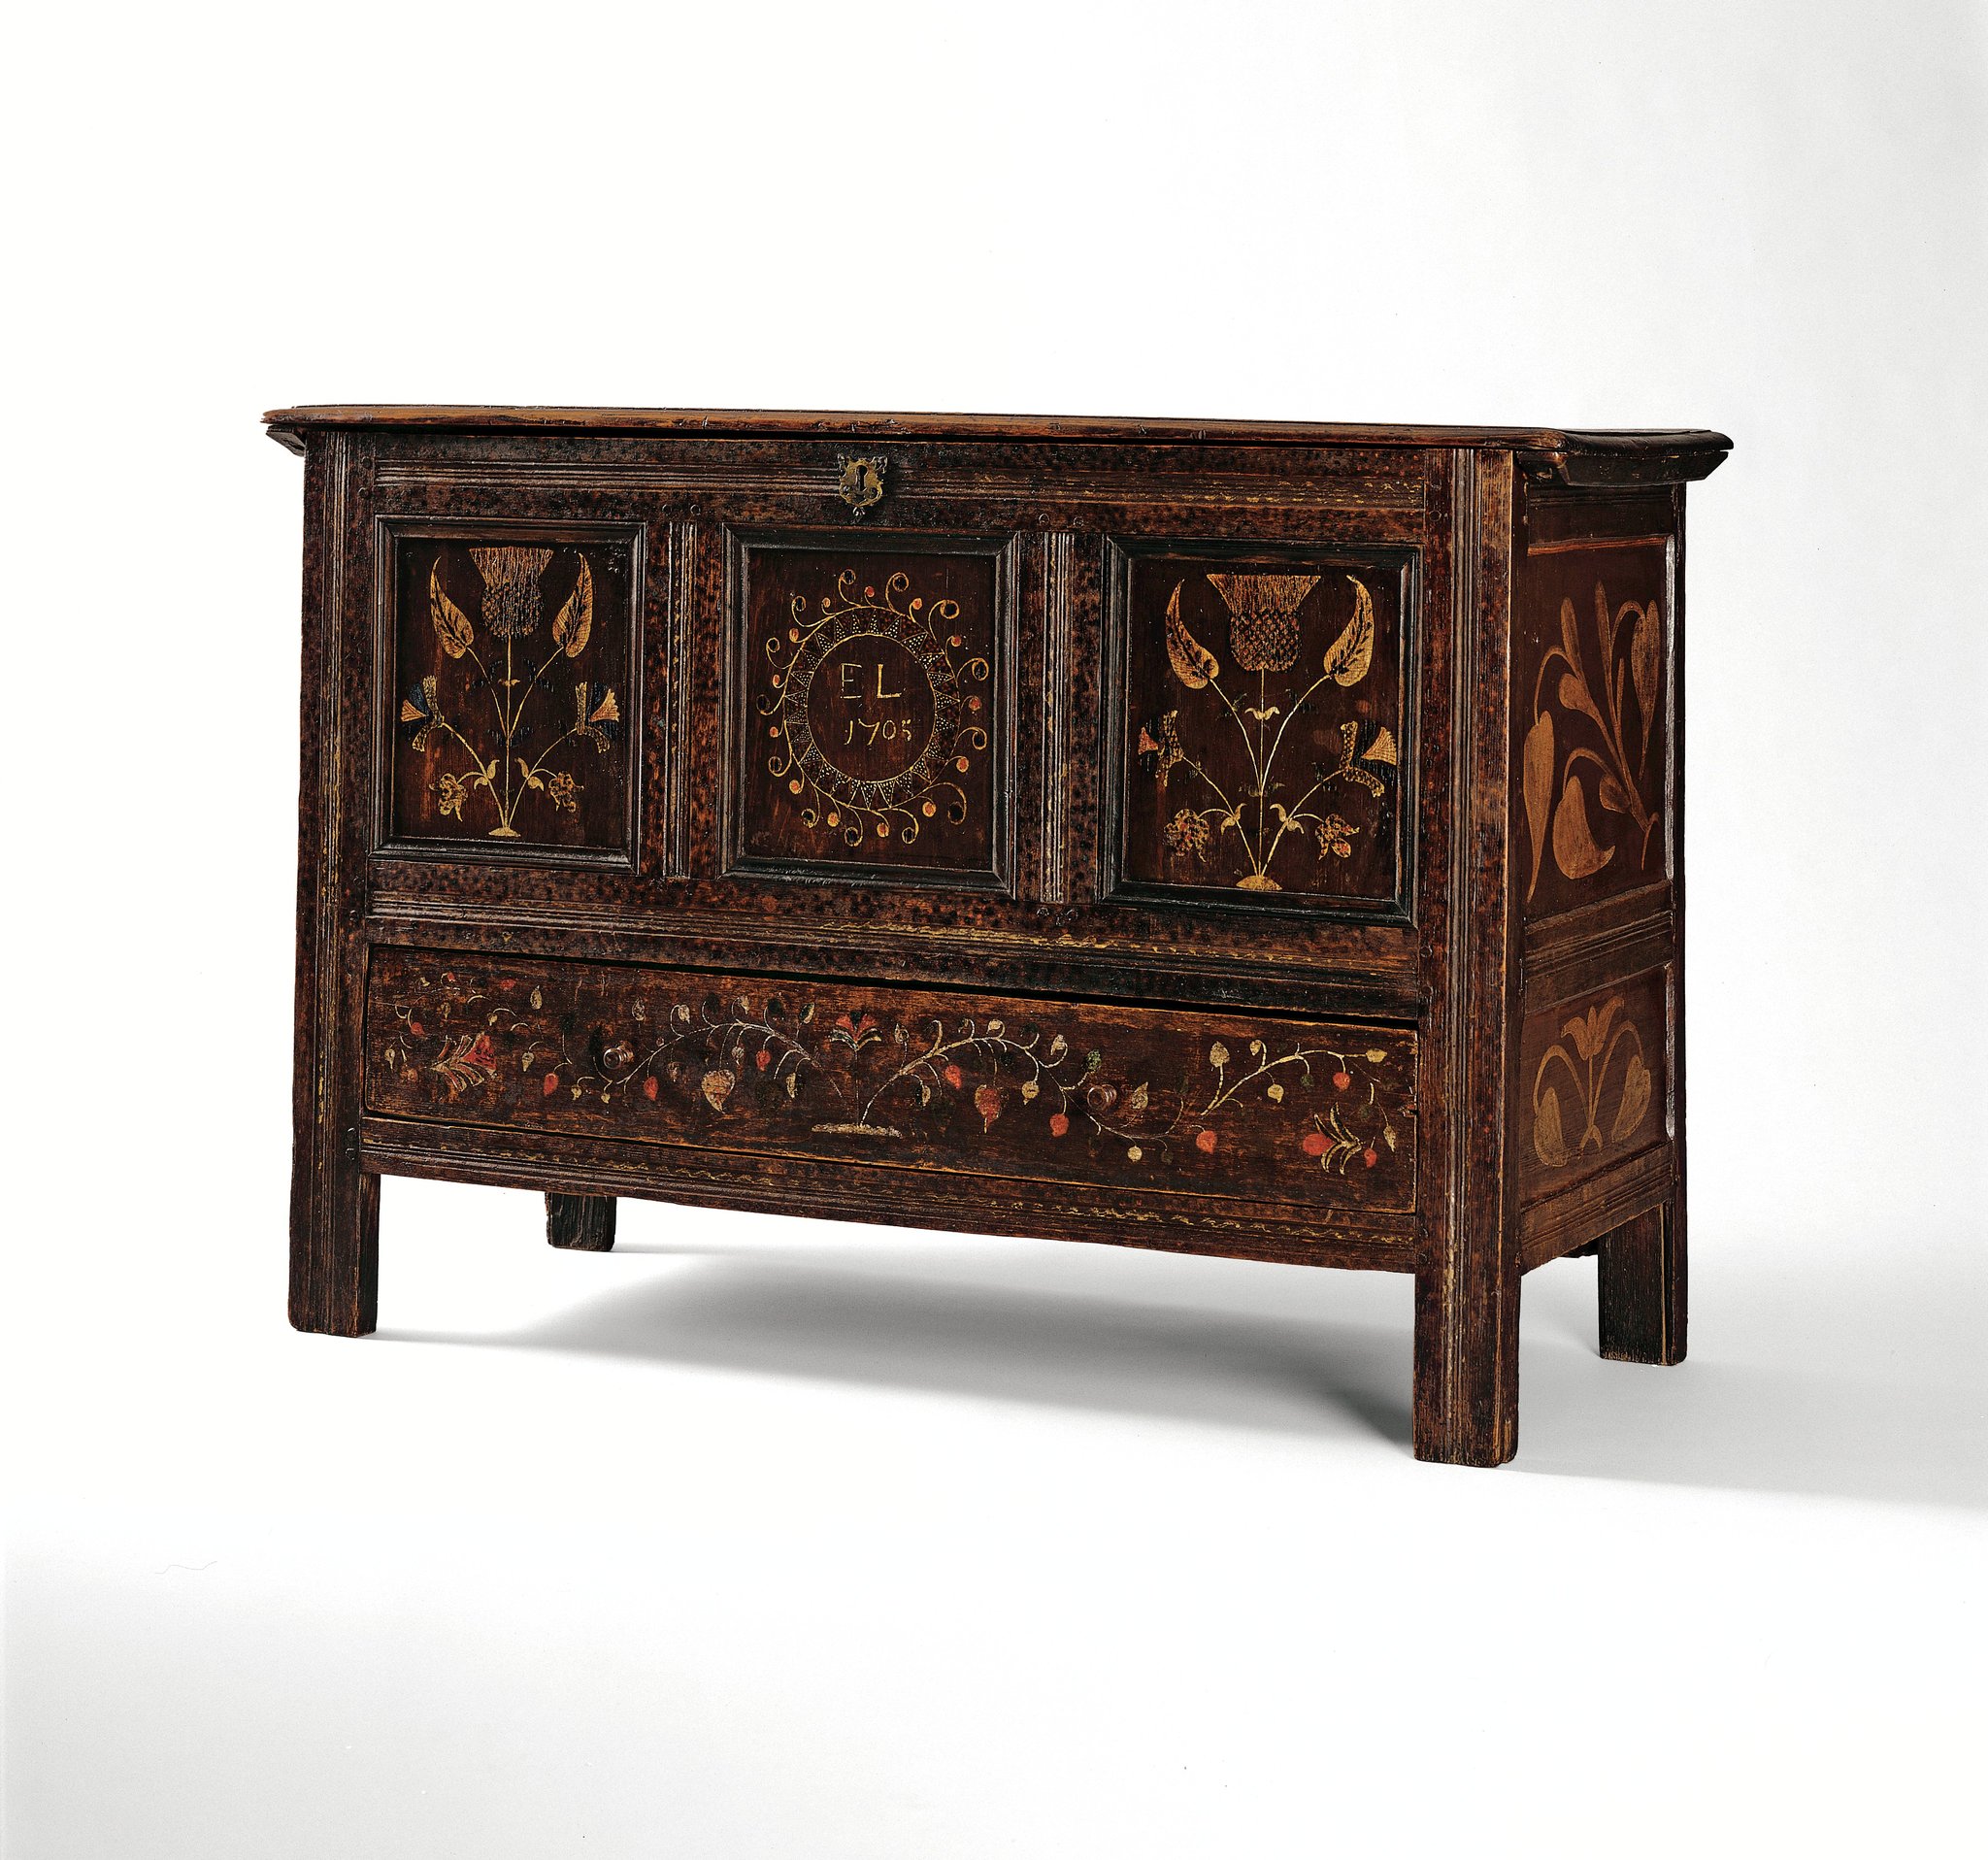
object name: chest of drawer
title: Chest with drawer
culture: american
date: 1705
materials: wood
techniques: painting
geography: united states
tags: flowers